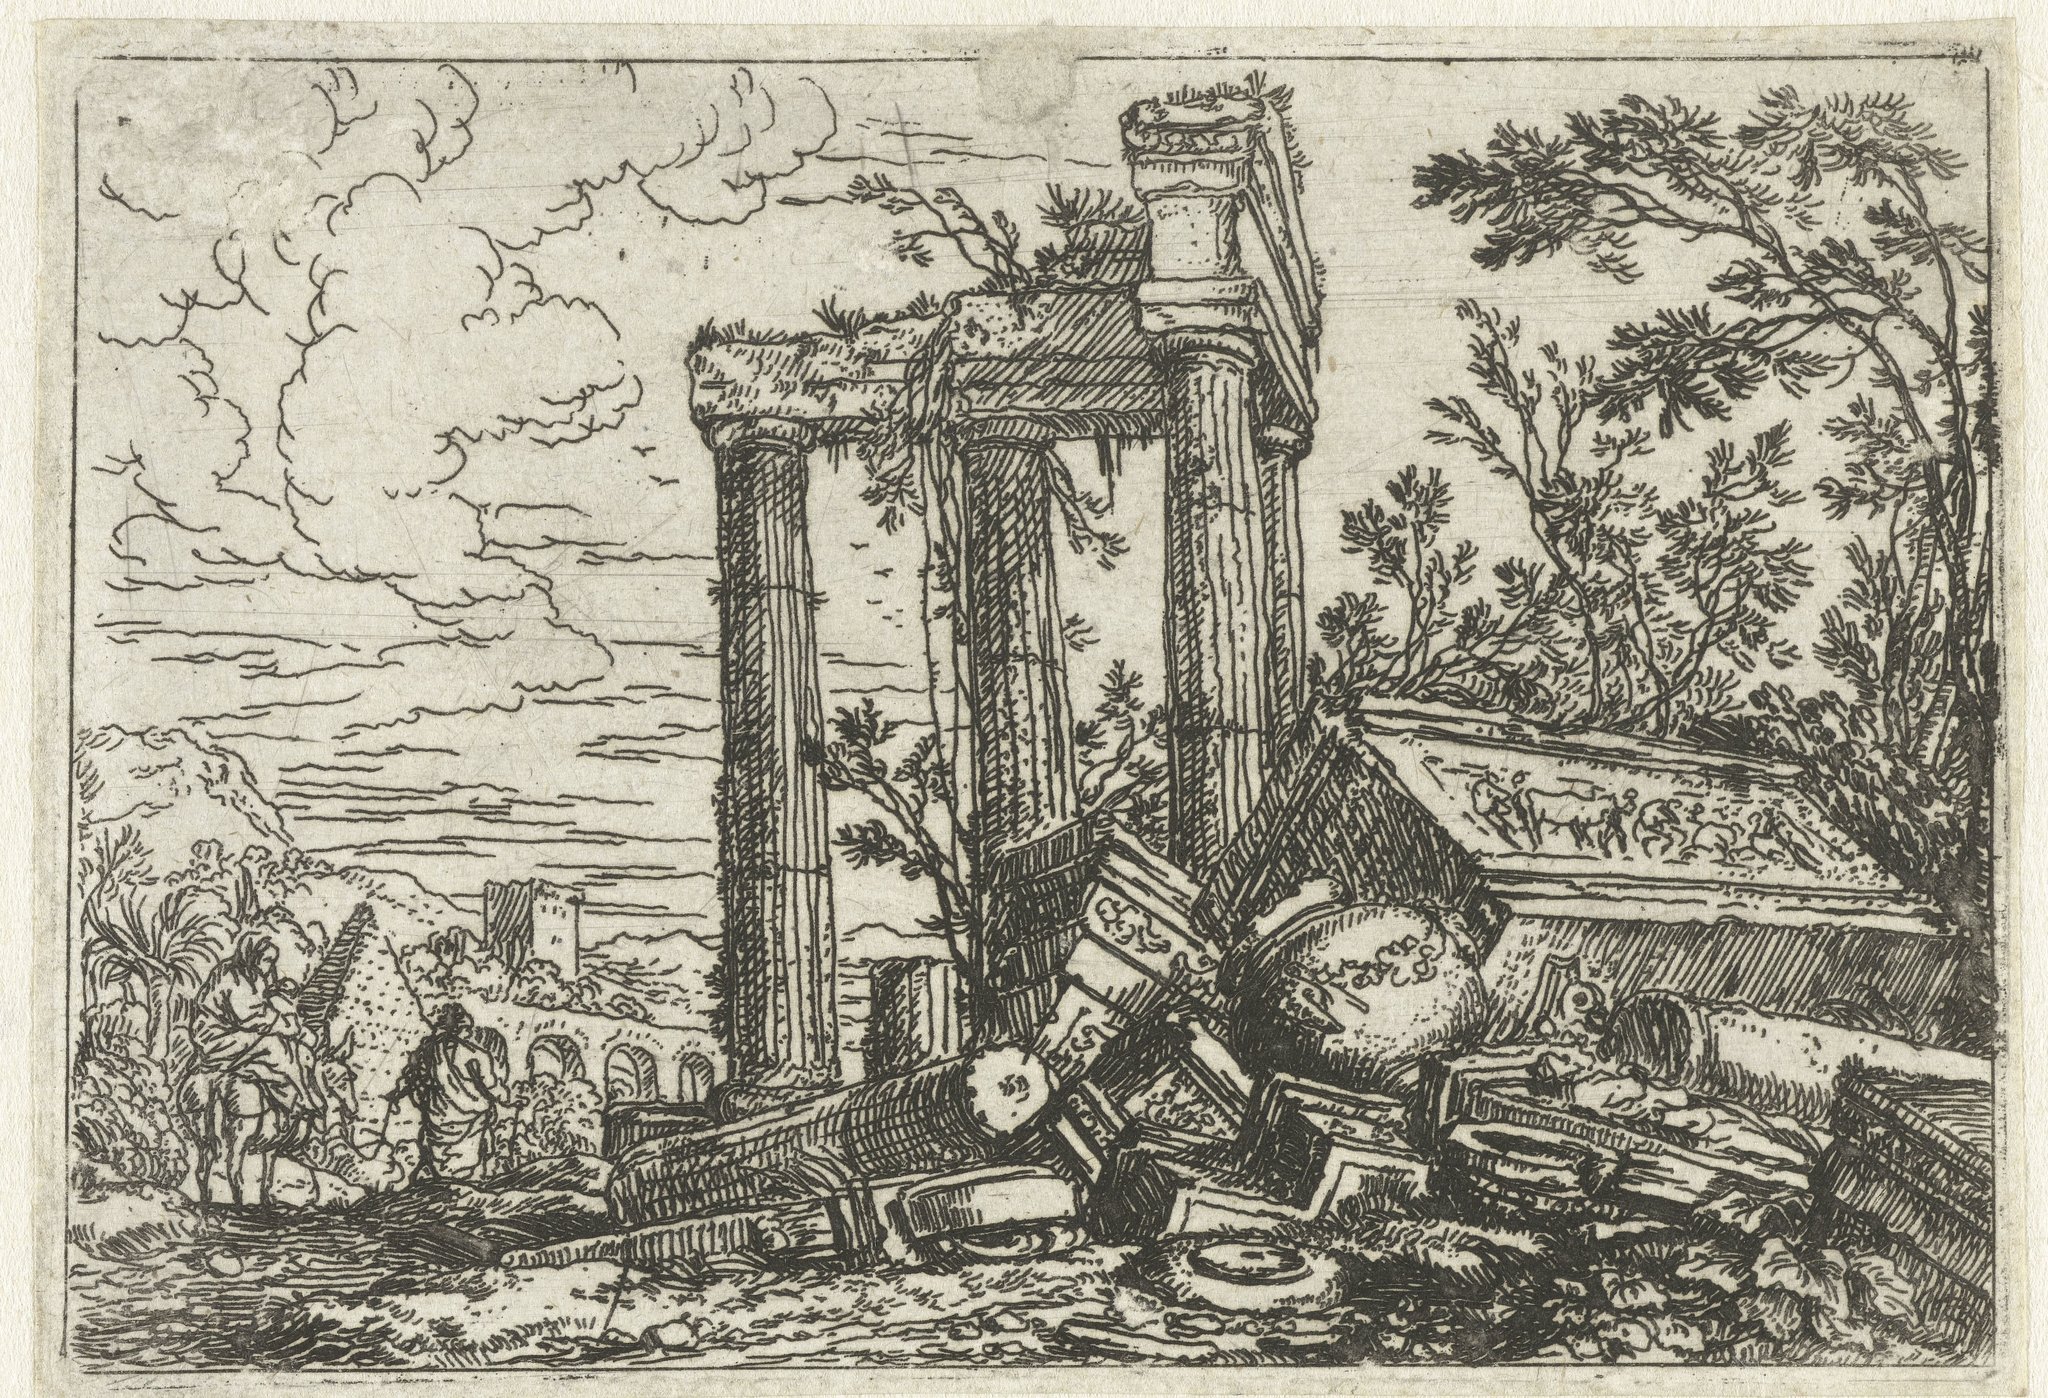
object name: print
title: Ruïnelandschap met de vlucht naar Egypte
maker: jonas umbach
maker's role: print maker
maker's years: 1624-1693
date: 1634-1693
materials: paper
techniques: etching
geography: augsburg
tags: the flight into egypt: mary, joseph, the child (and sometimes others) on their way; mary usually riding on an ass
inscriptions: collector's mark: Lugt 240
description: Landschap met een ruïne van een tempel. Links Maria met het Christuskind op een ezel, geleid door Jozef.